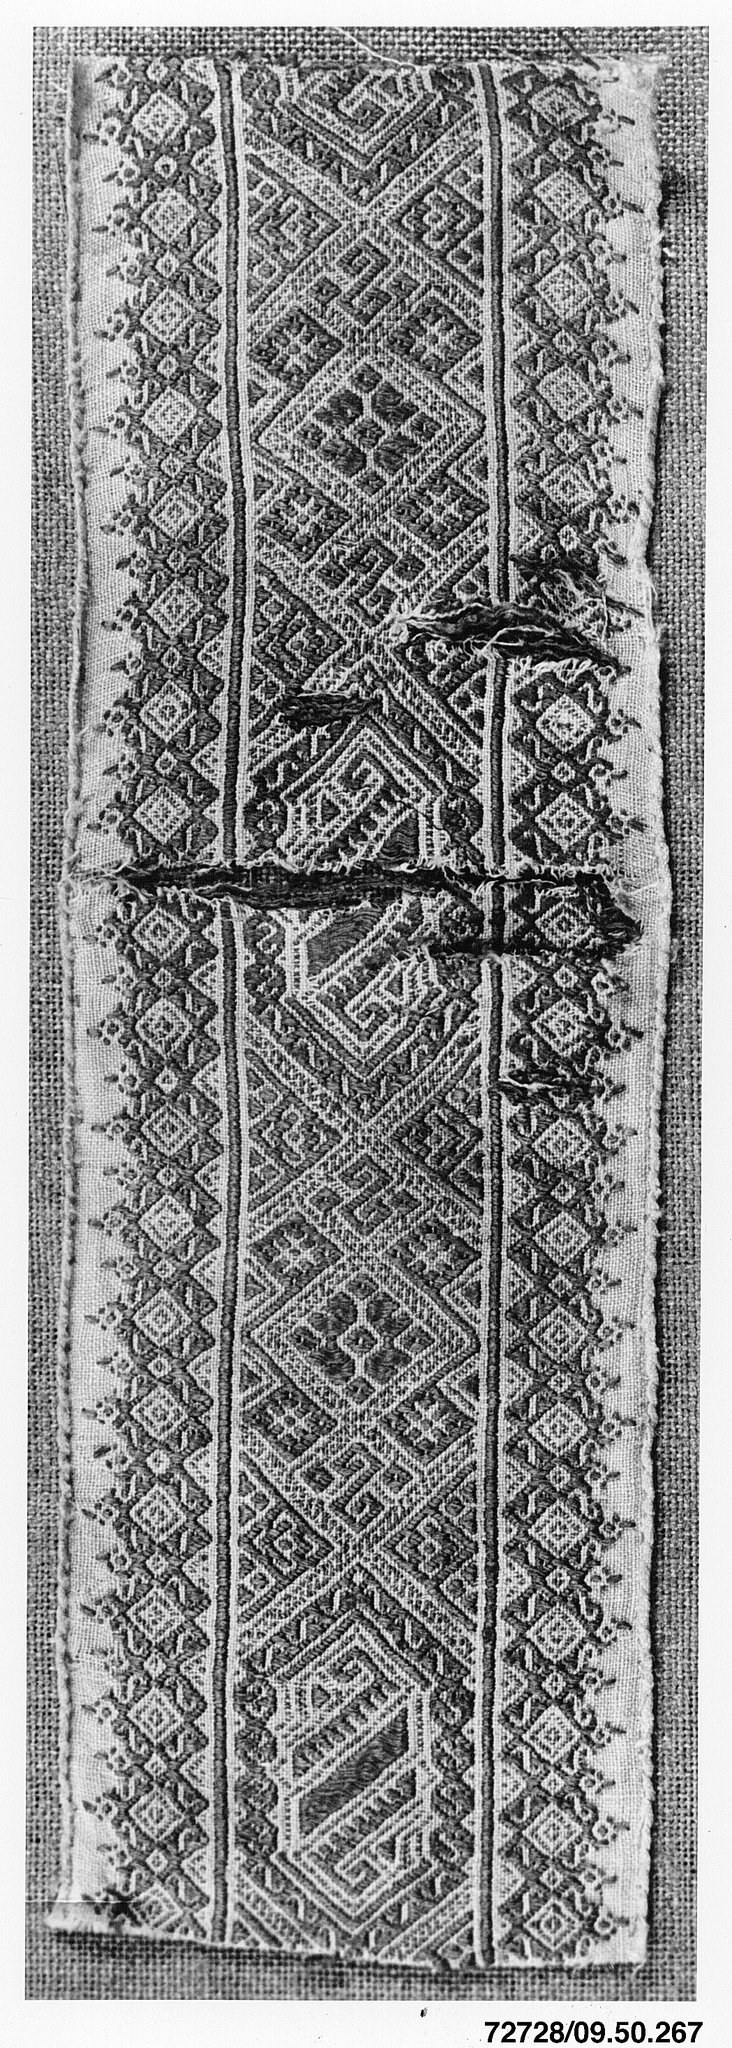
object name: band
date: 1701-1800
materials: linen, silk